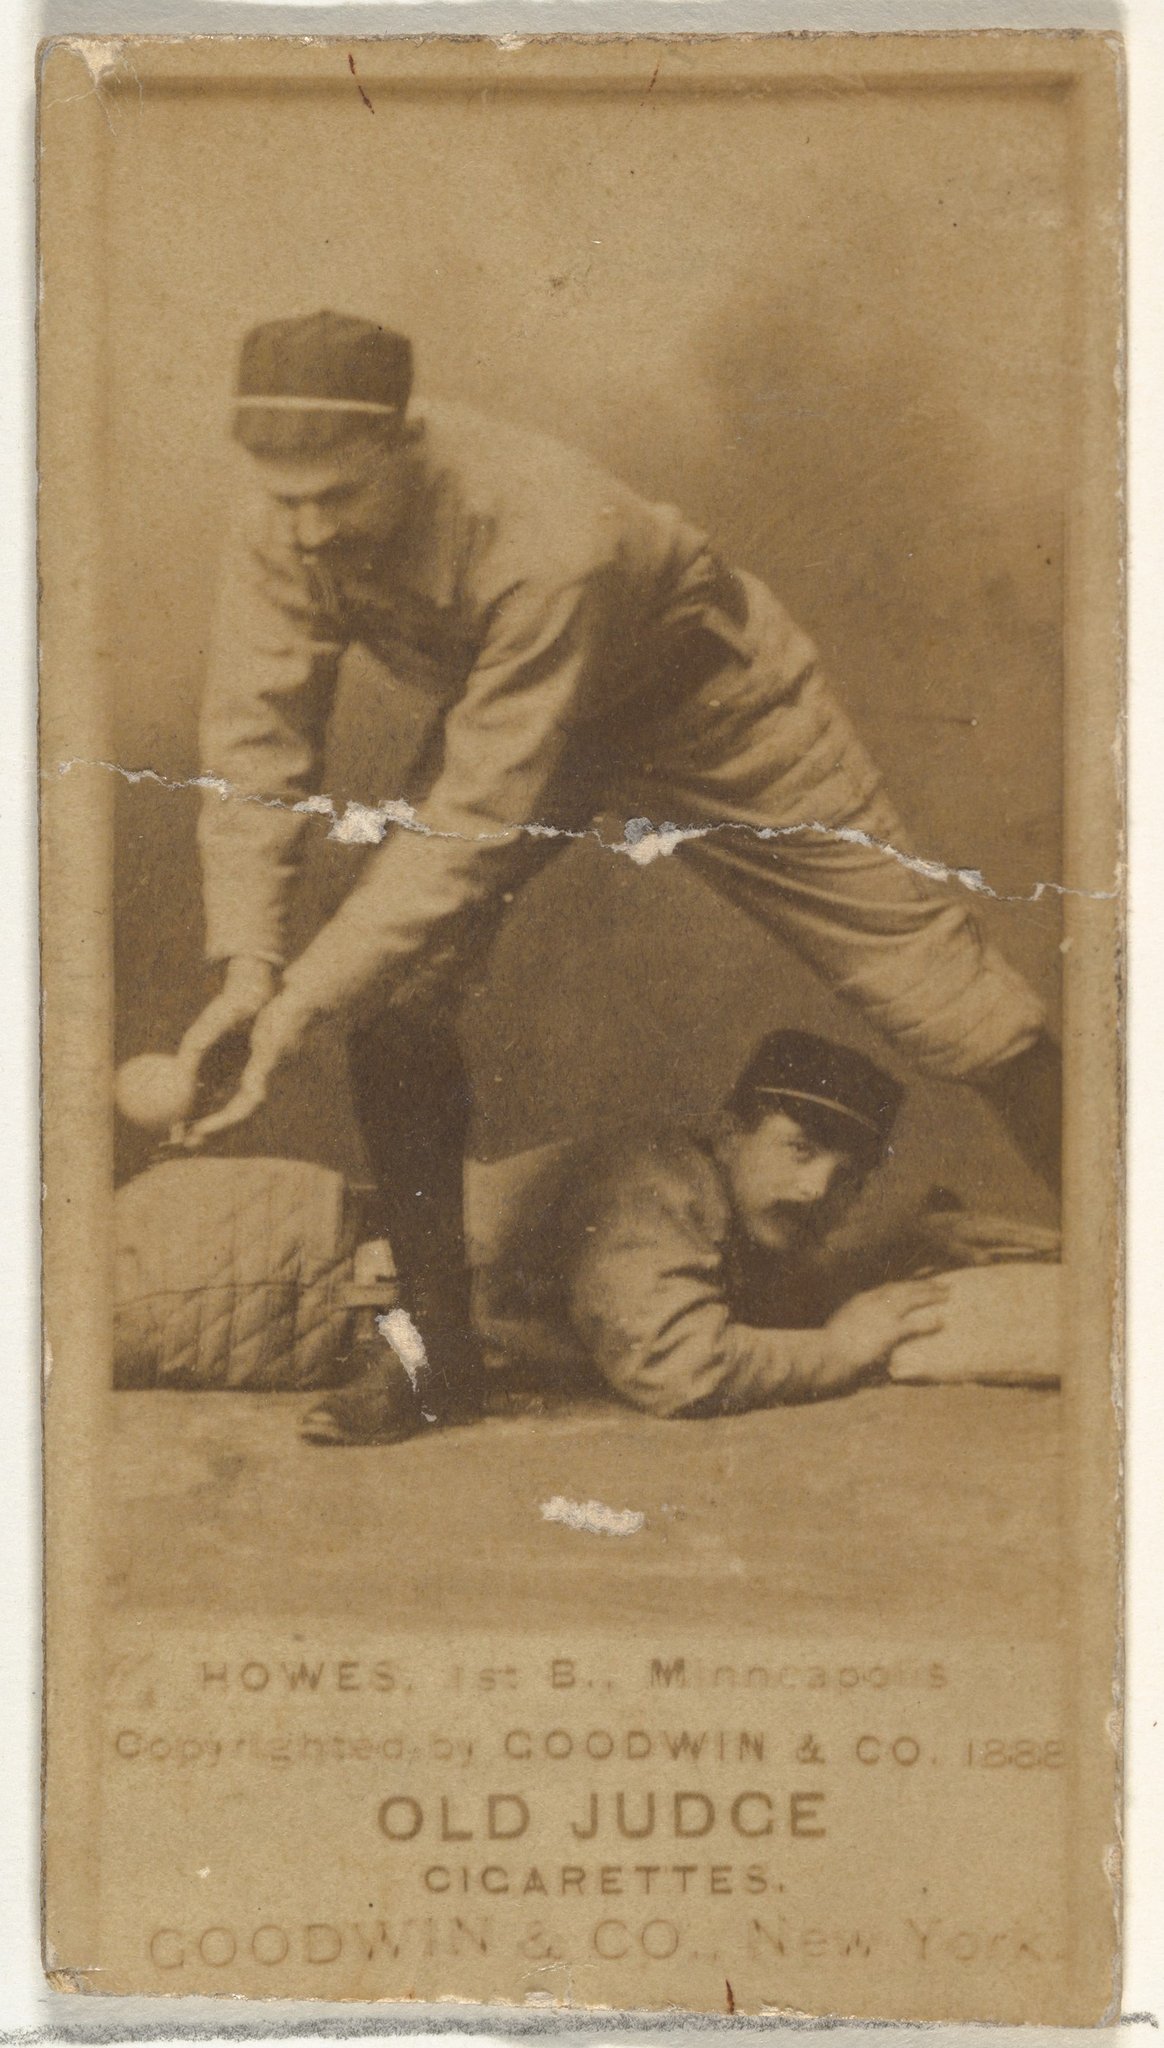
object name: baseball card, photograph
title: William Hildreth "Bill" Hawes, 1st Base, Minneapolis, from the Old Judge series (N172) for Old Judge Cigarettes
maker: goodwin & company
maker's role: publisher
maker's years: 1850-1950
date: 1888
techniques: albumen silver print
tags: men,portraits,baseball,athletes